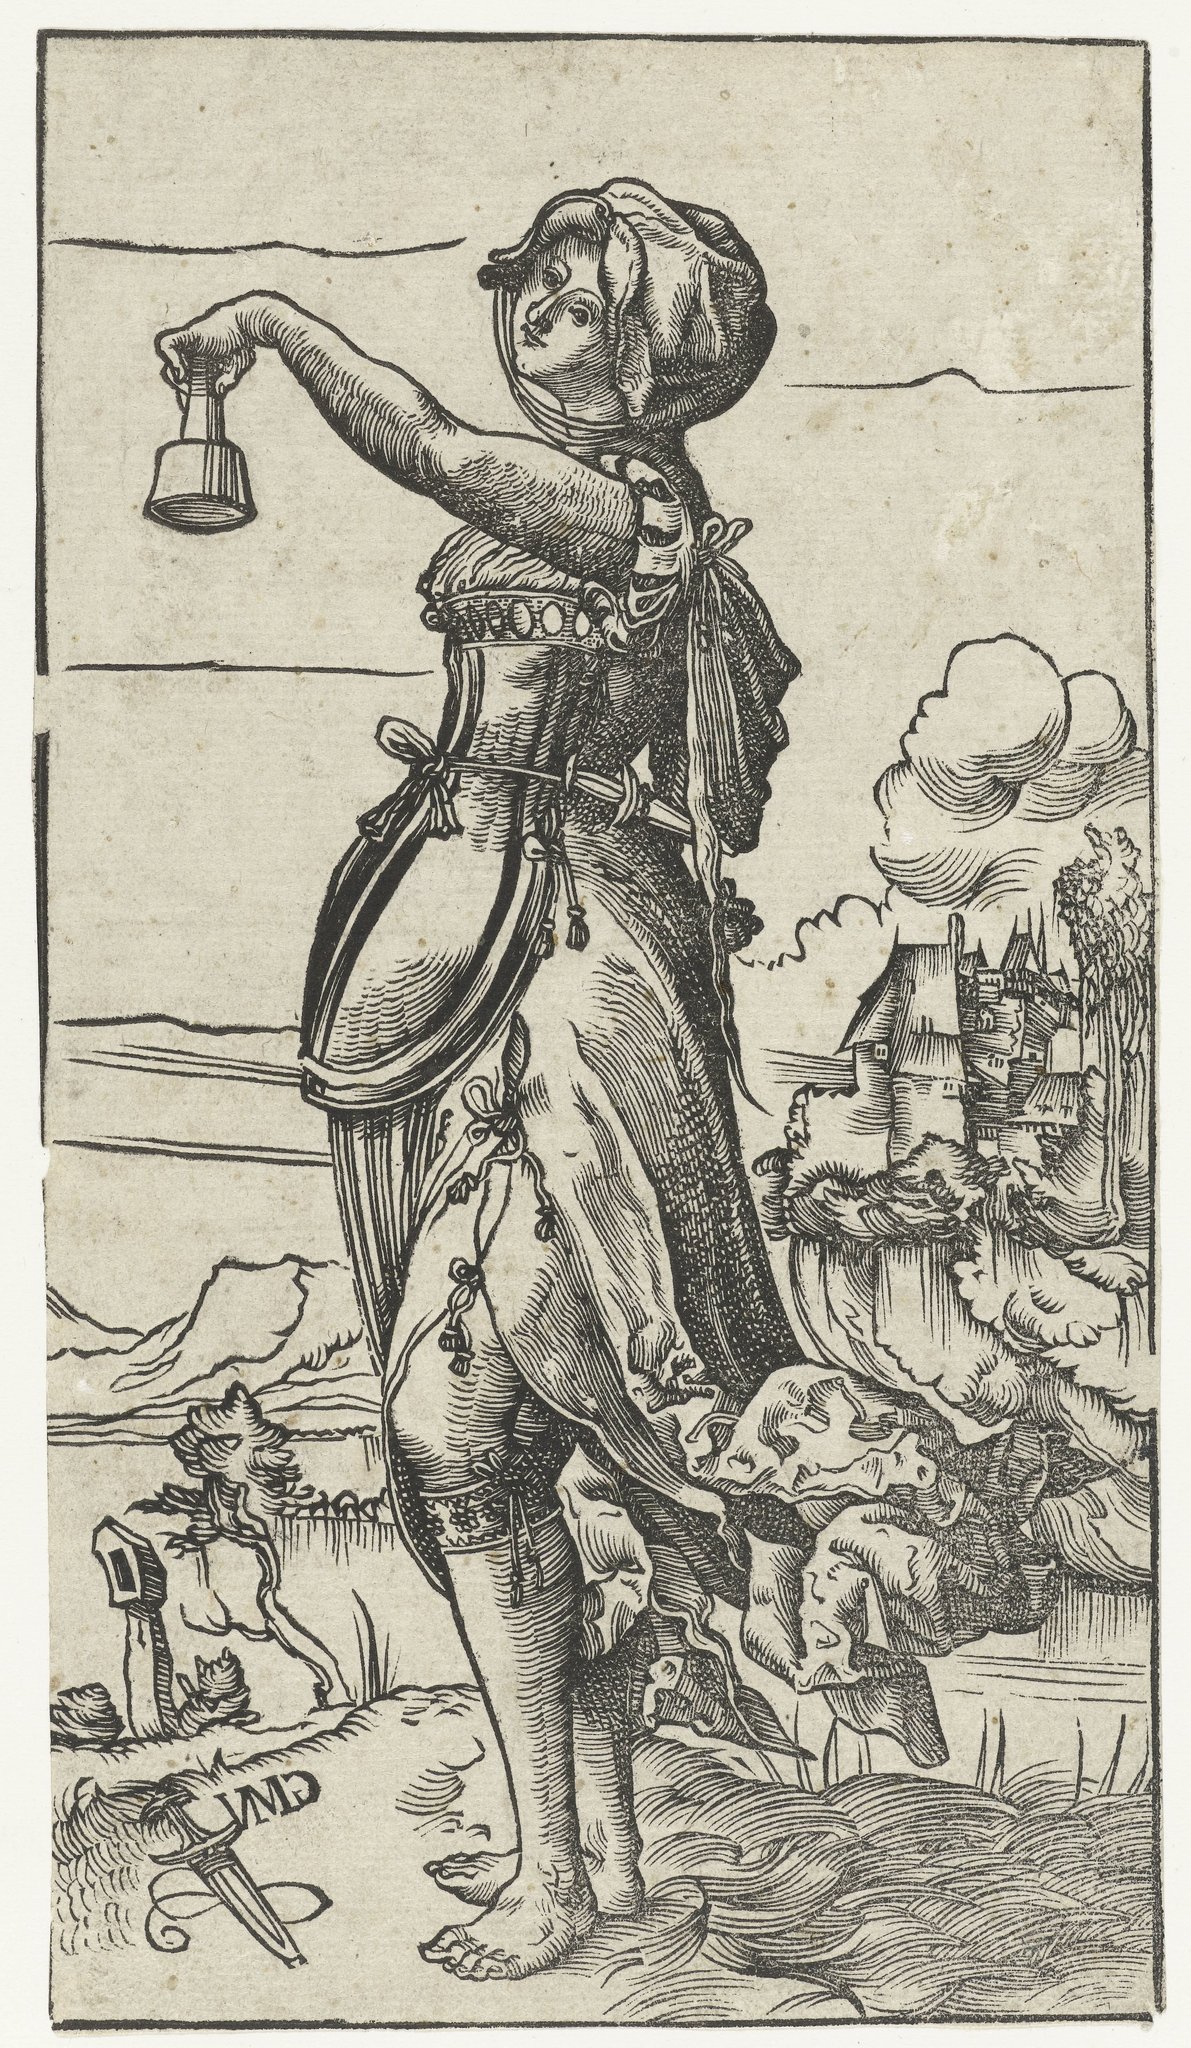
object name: print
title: Vijf wijze en vijf dwaze maagden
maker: niklaus manuel deutsch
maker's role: print maker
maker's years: 1484-1530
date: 1518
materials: paper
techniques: woodcut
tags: the wise and the foolish virgins ~ parable of christ (matthew 25:1-13)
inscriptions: collector's mark: Lugt 2760, collector's mark: Lugt 2228a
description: Dwaze maagd staand op blote voeten, een deel van haar naakte bovenbeen zichtbaar onder haar kleding. Zij staat naar links gewend terwijl ze haar olielamp in haar uitgestrekte hand houdt.